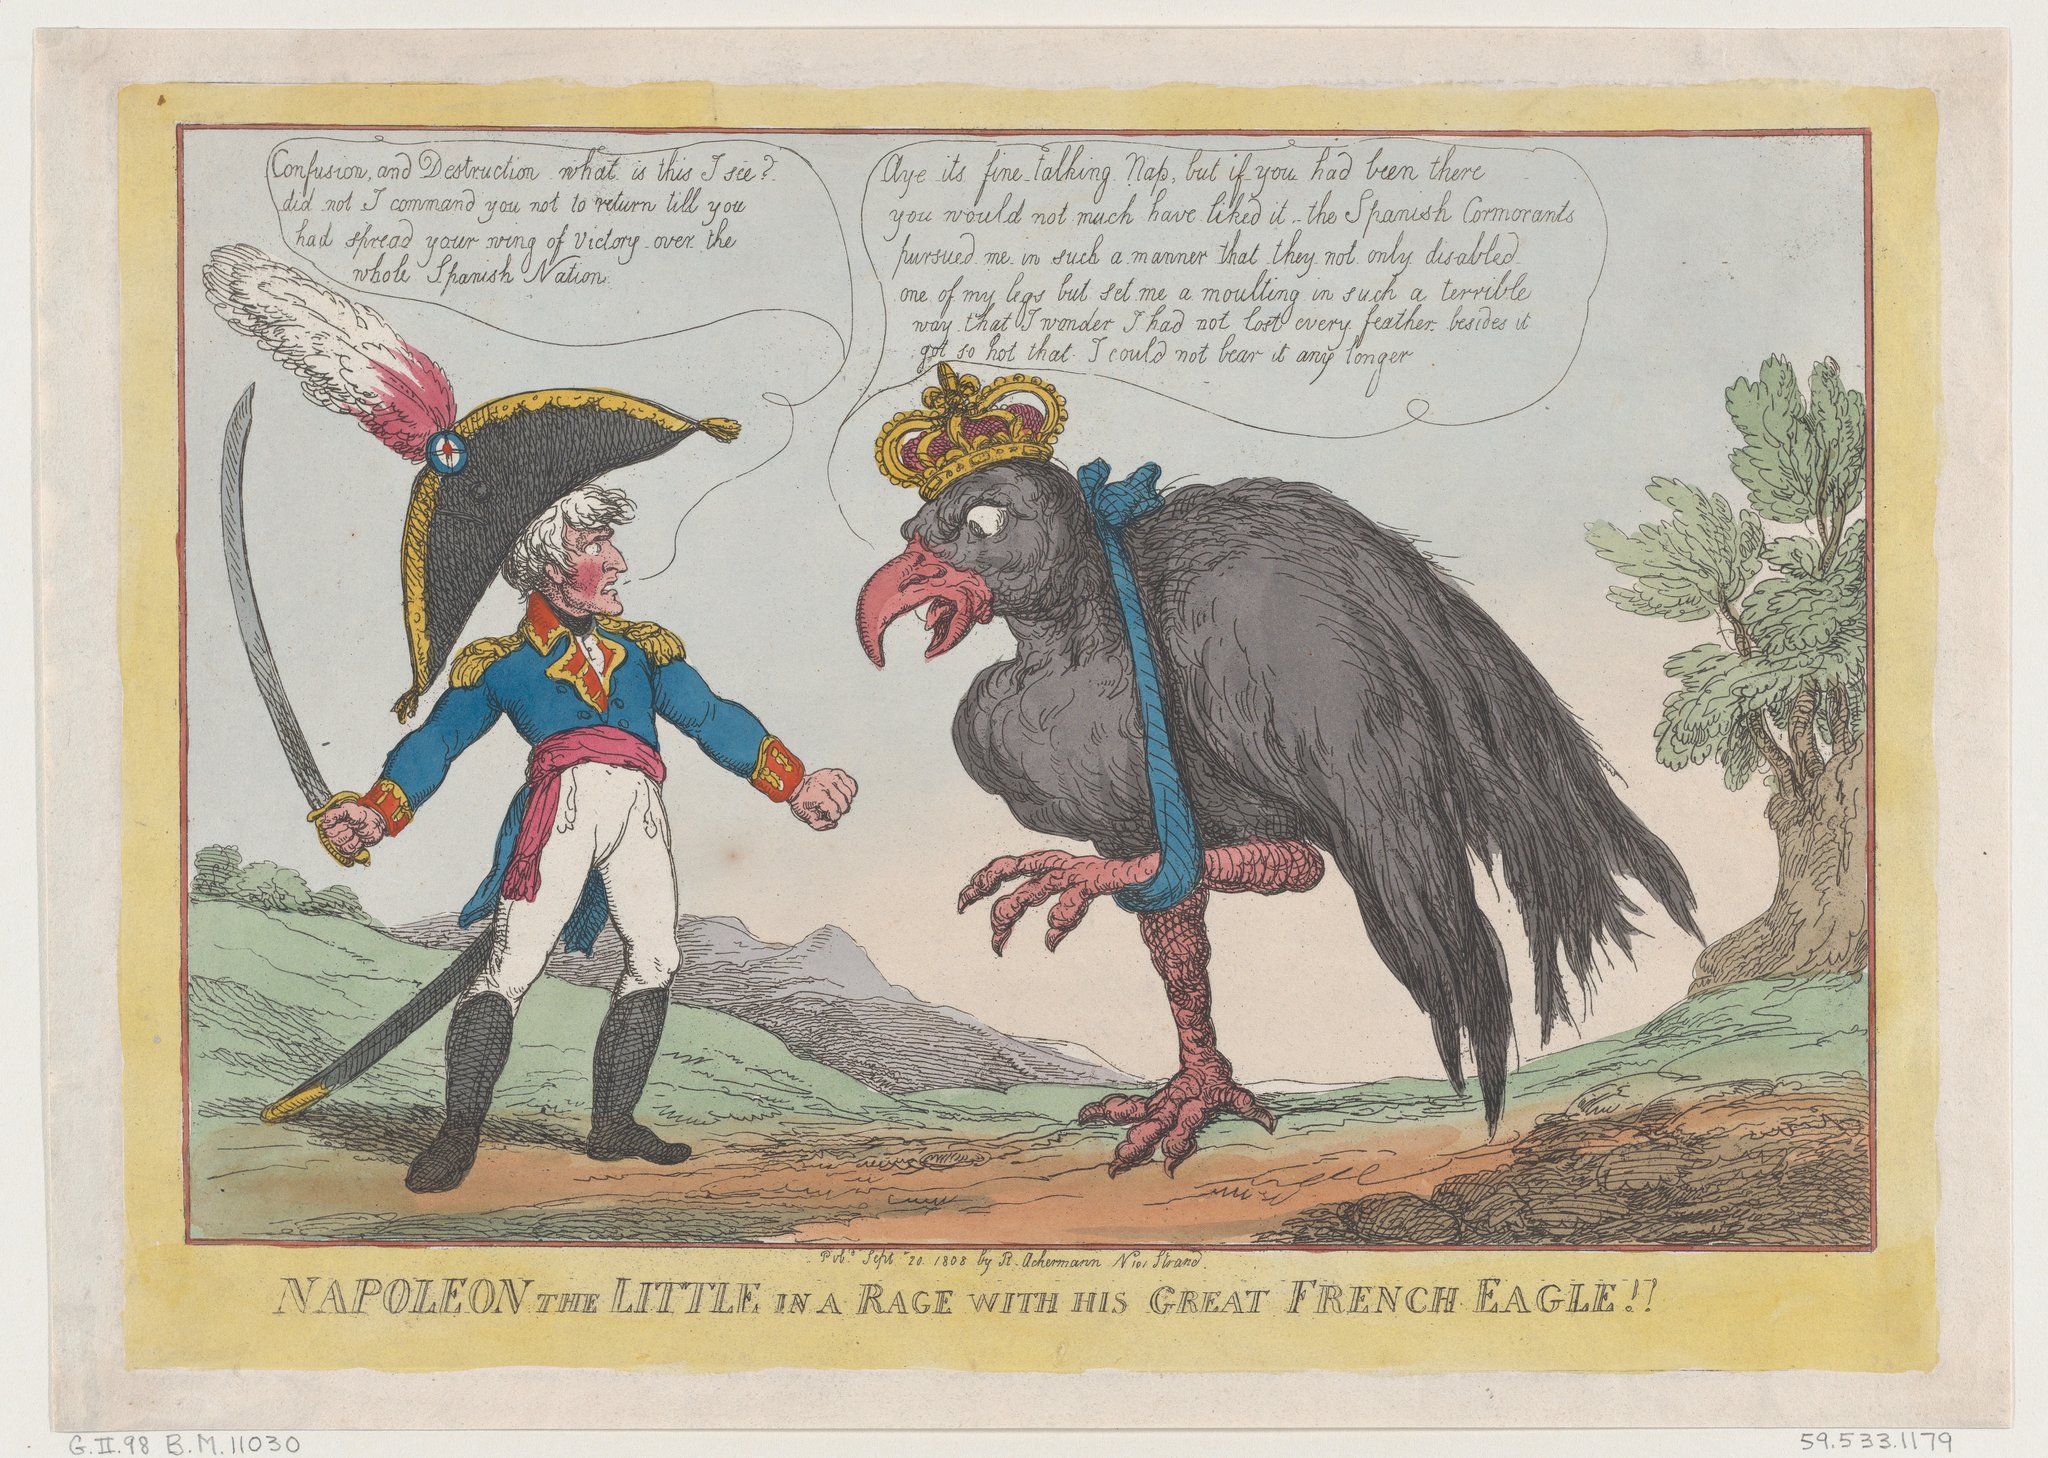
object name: print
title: Napoleon The Little in a Rage with His Great French Eagle!!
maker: thomas rowlandson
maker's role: artist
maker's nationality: british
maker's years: 1757-1827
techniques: etching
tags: eagles,satire,napoleon i,politics